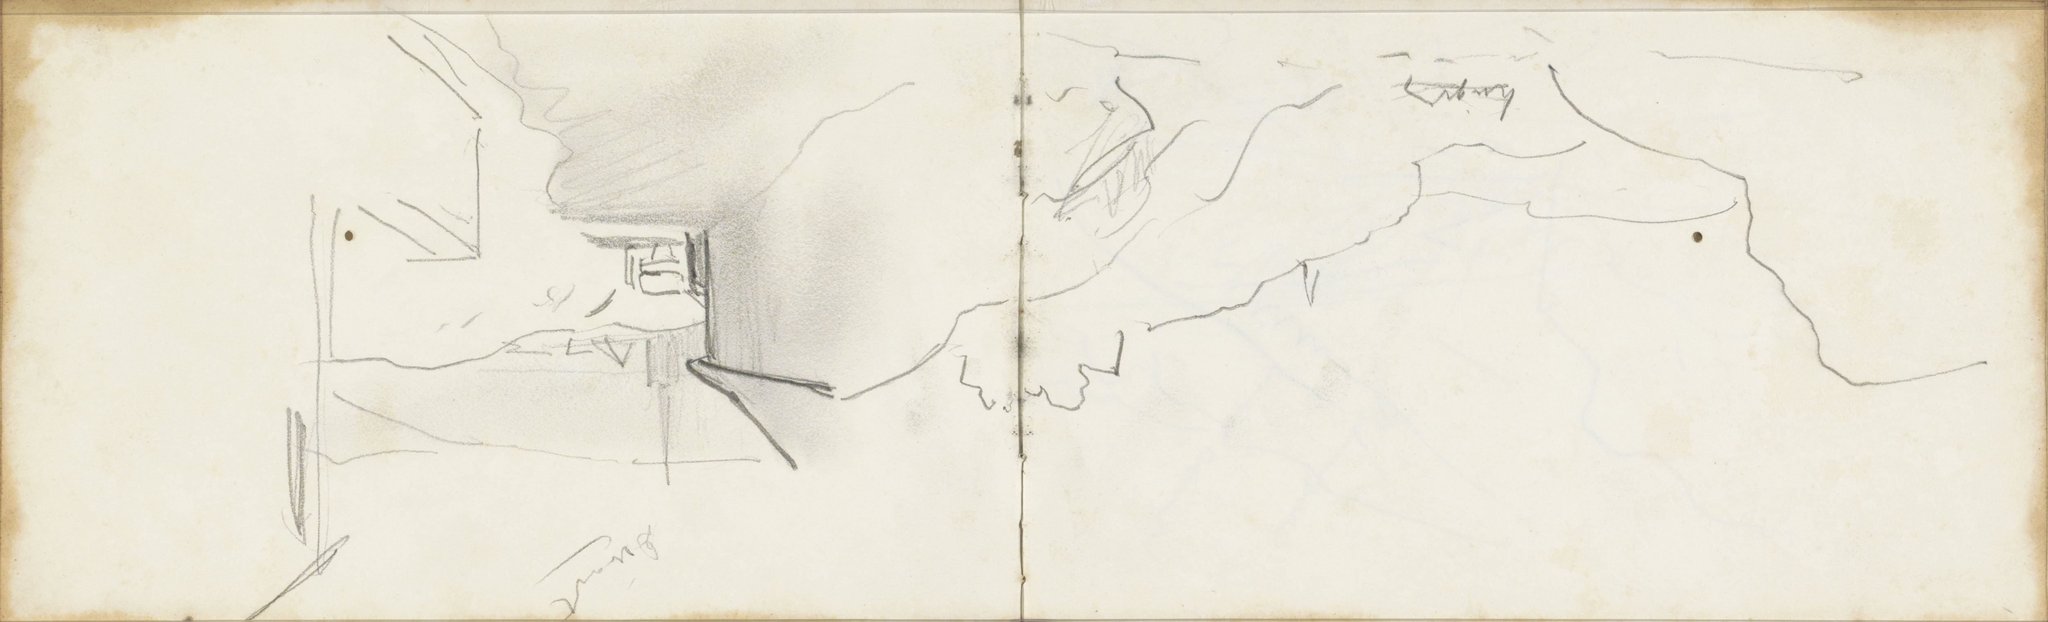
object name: sketchbook leaf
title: Straat in Dinant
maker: johannes tavenraat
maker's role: draughtsman, painter, print maker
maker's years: 1809-1881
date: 1840-1841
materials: paper, pencil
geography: dinant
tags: street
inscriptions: annotation: ‘Liege?/ Dinant’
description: Blad 8 verso en 9 recto uit een schetsboek met 41 bladen.